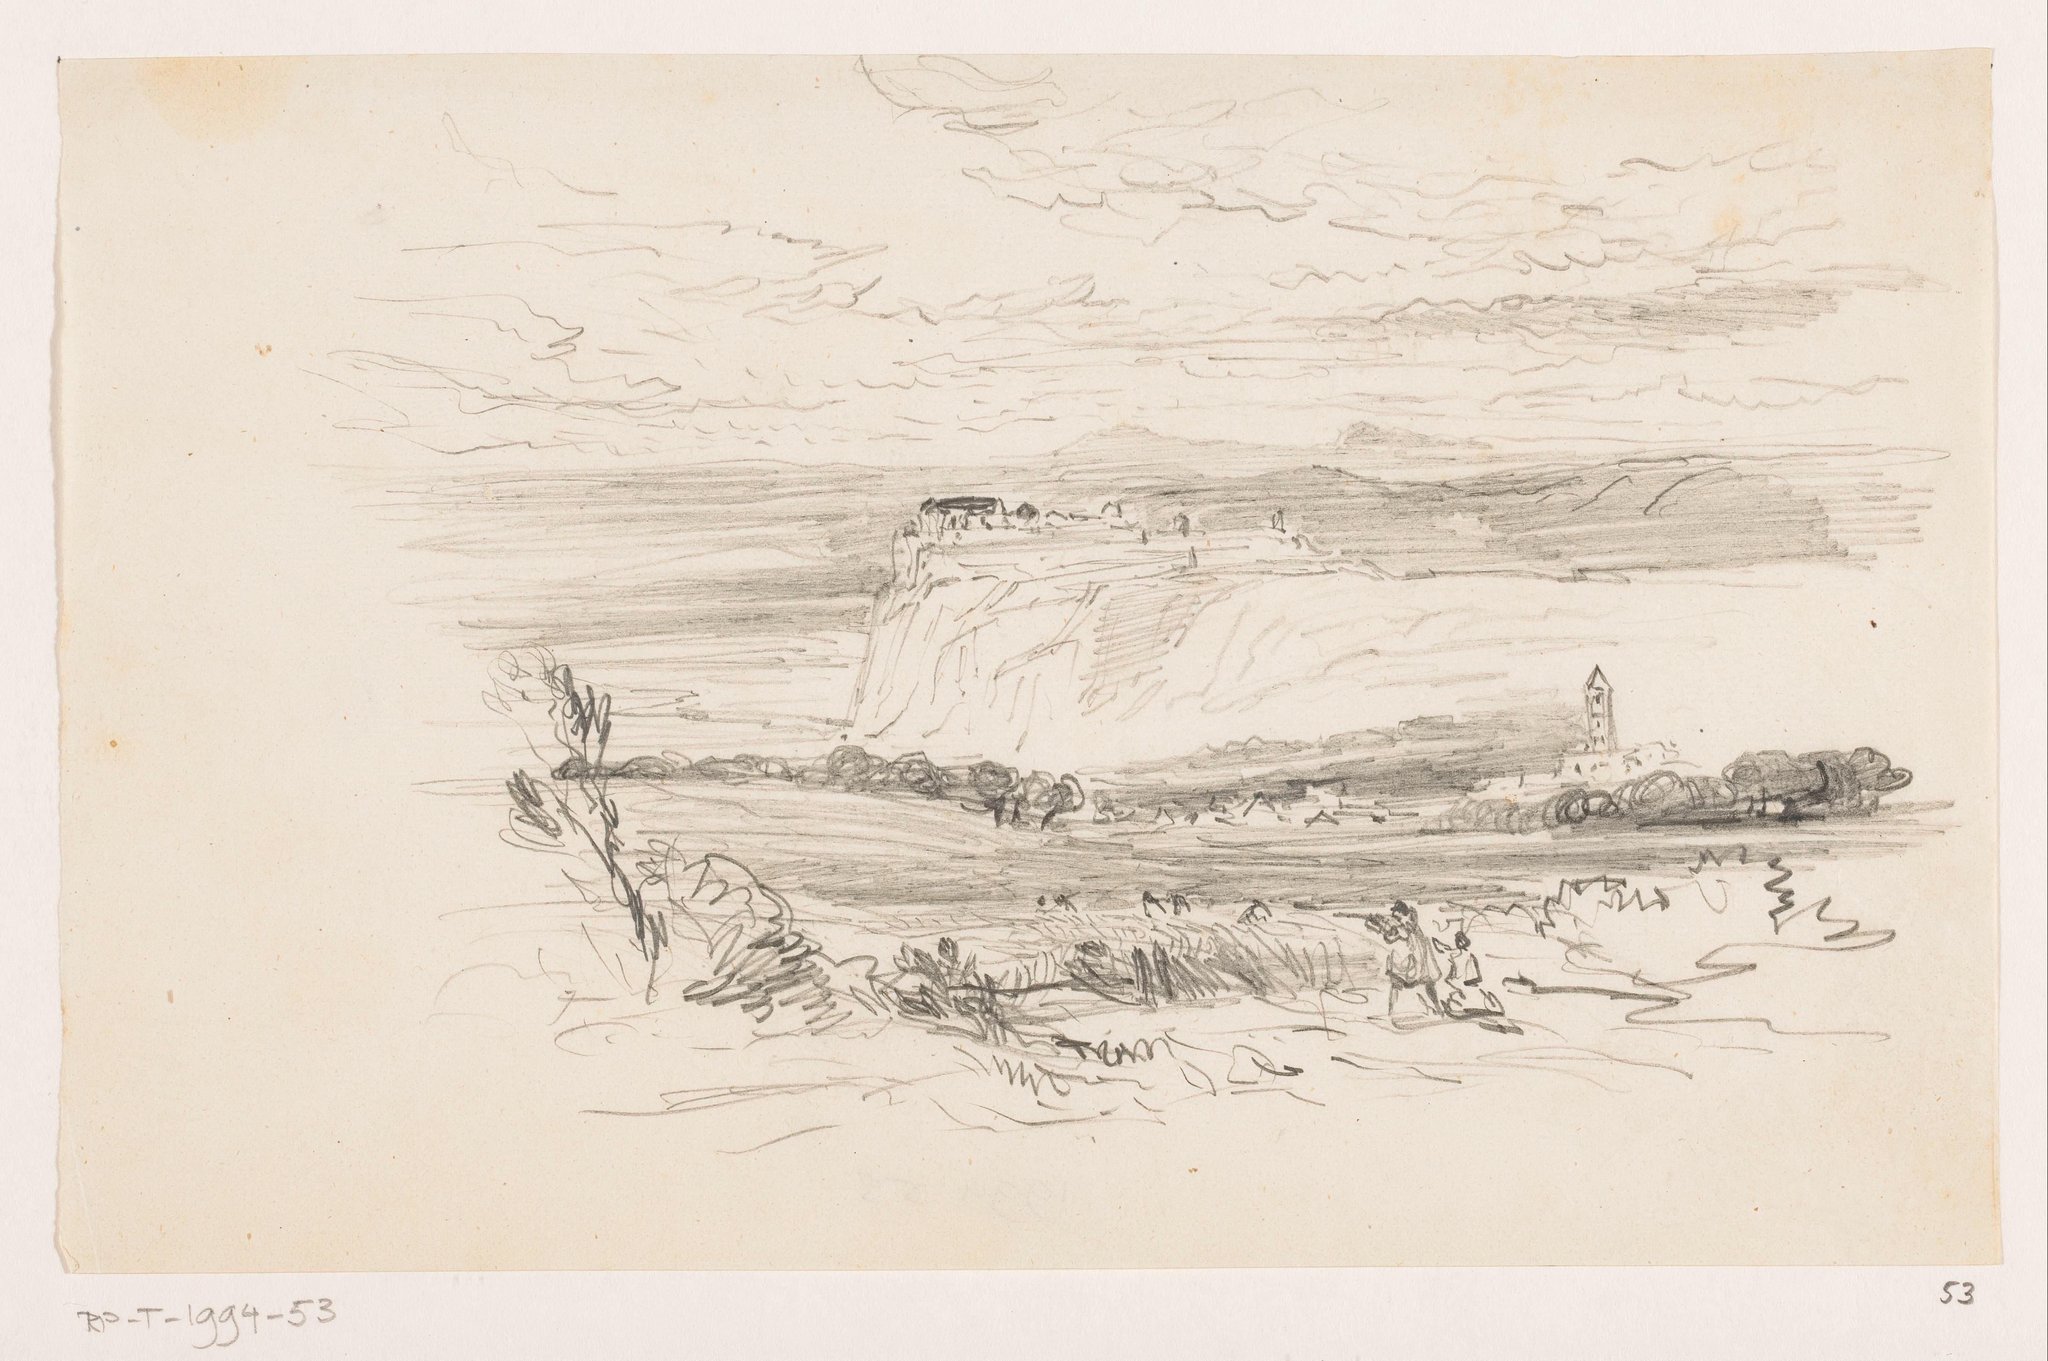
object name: drawing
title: Landschap met burcht of klooster op hoge rots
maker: johannes tavenraat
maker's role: draughtsman, painter, print maker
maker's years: 1809-1881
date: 1819-1881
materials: paper, pencil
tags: inland cliff face (+ landscape with figures, staffage)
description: Landschap met burcht of klooster op hoge rots. Op de voorgrond een jager.